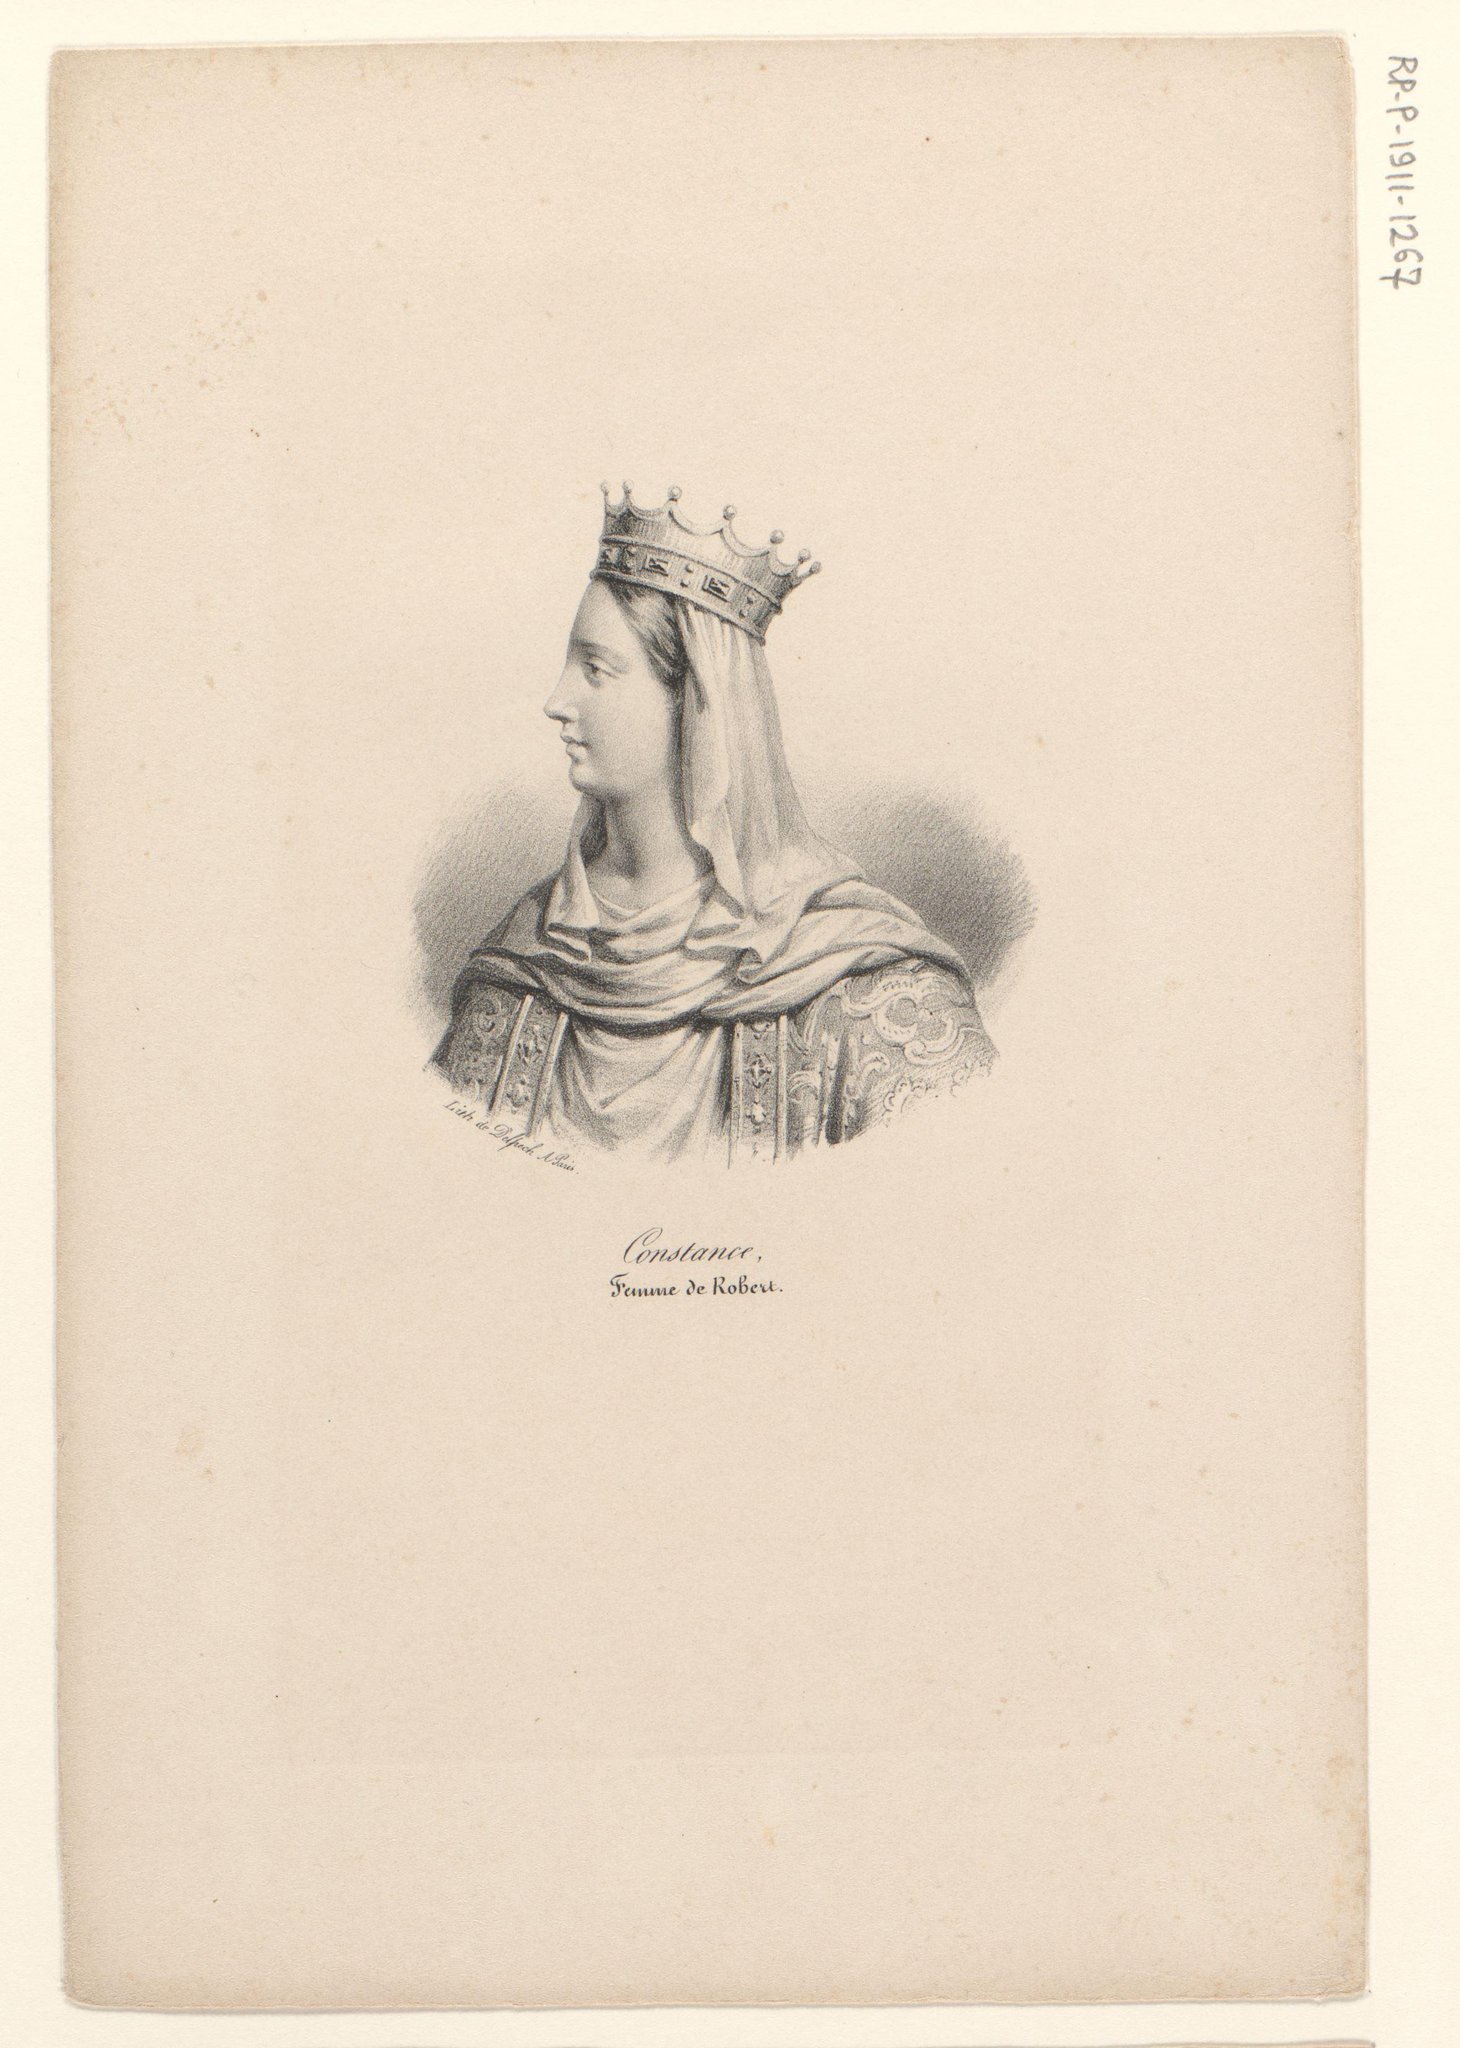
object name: print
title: Portret van Constance van Arles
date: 1818-1842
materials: paper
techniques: lithograph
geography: paris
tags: historical persons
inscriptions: collector's mark: Lugt 2228a